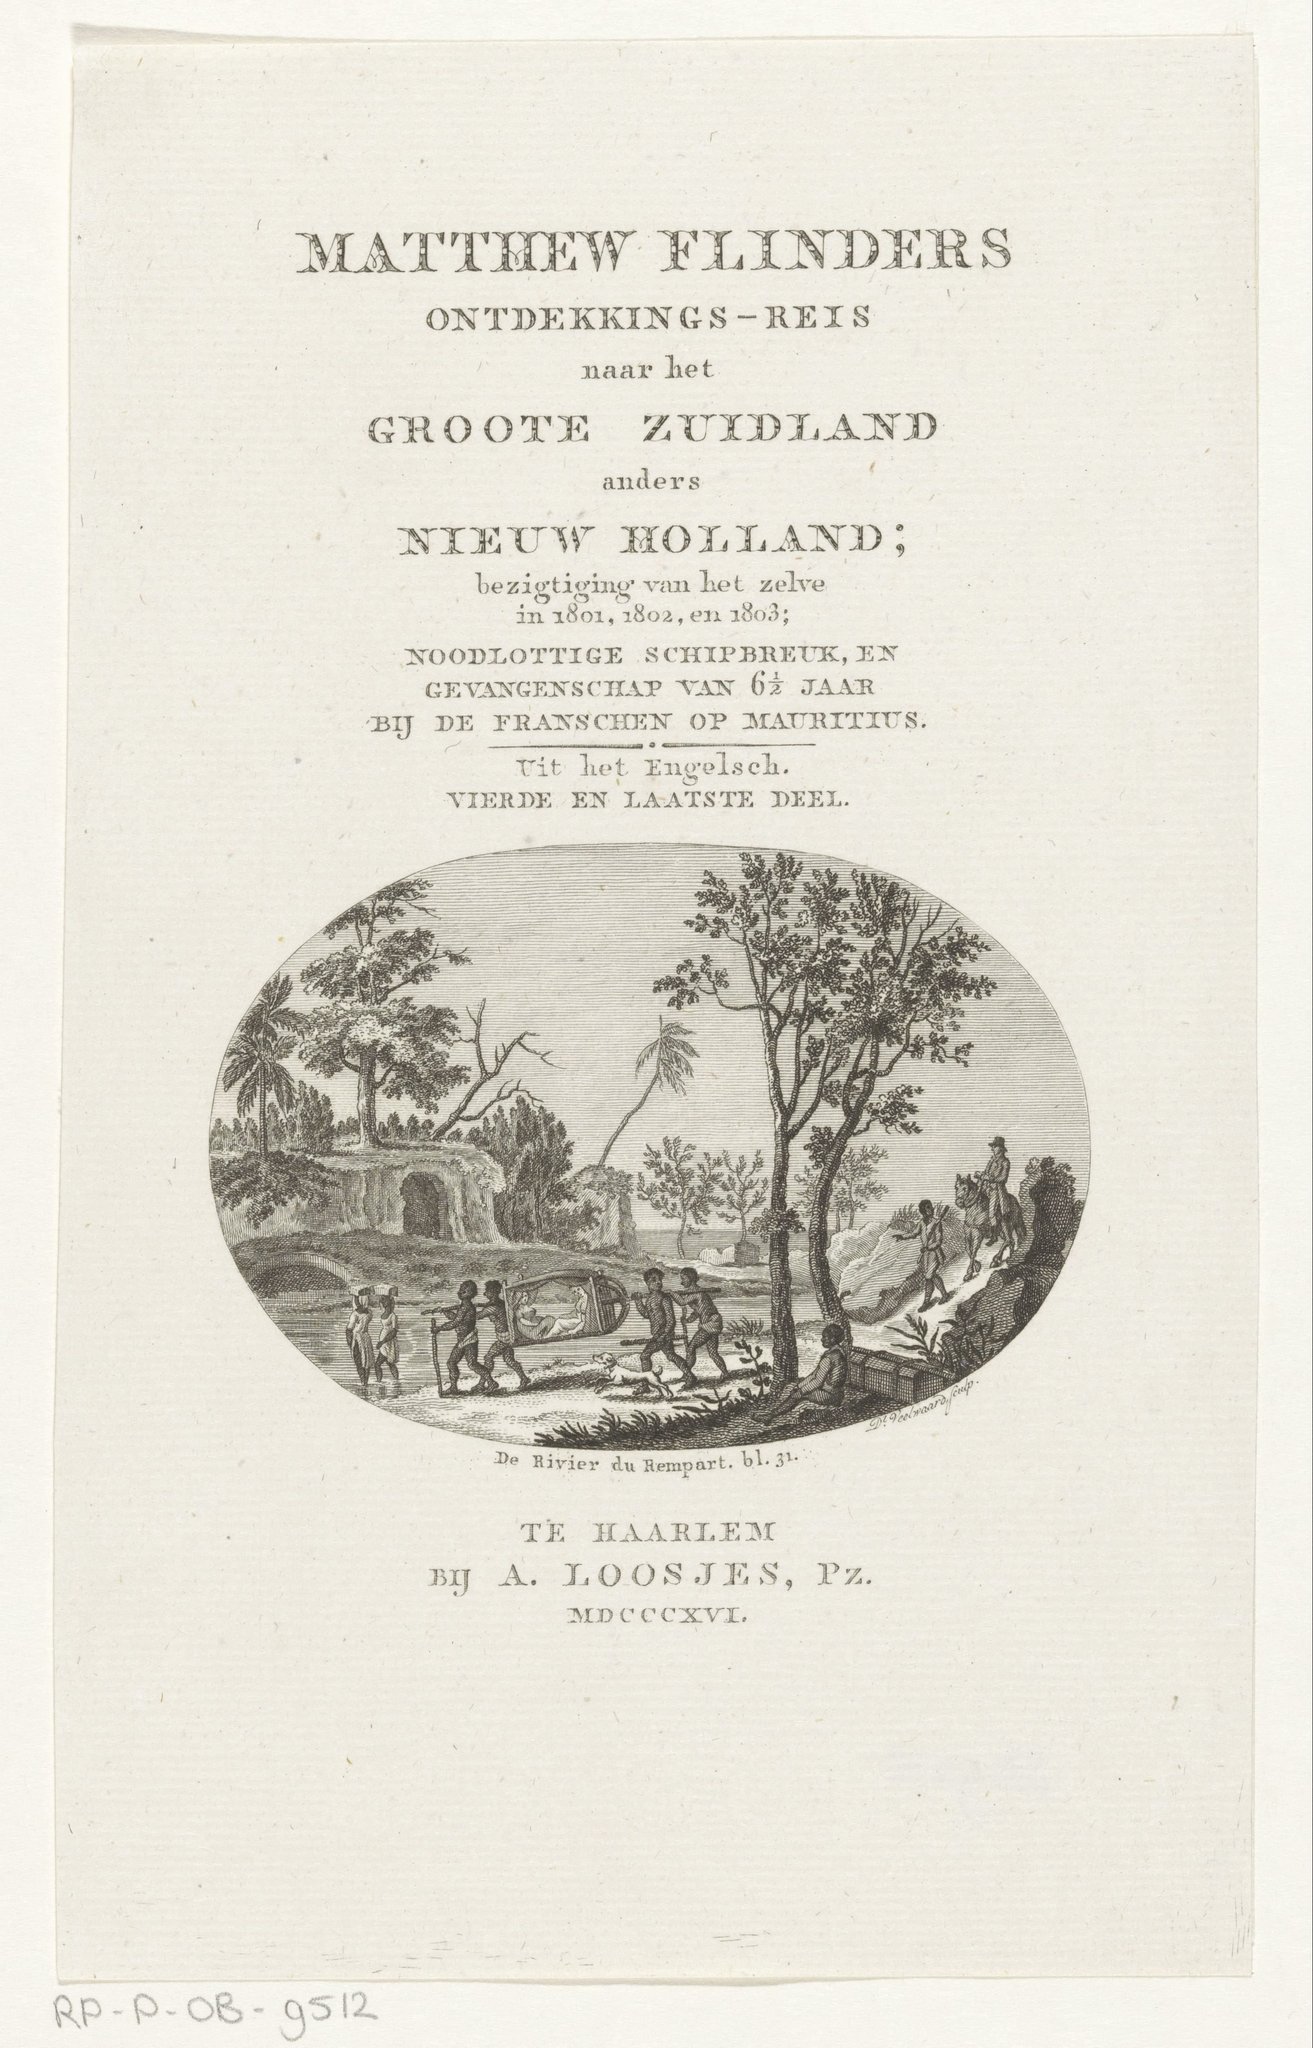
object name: titelblad, titelpagina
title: De rivier du Rempart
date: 1816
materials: paper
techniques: engraving, etching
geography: haarlem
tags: carrying a person, river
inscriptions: collector's mark: Lugt 2228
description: Vier Mauritianen lopen langs een rivier, Rivière du Rempart, in Mauritius en dragen twee westerse vrouwen in een draagstoel. Achter hen op het pad loopt een Mauritiaan voor een westerse man te paard. In de rivier staan twee Mauritiaanse vrouwen.